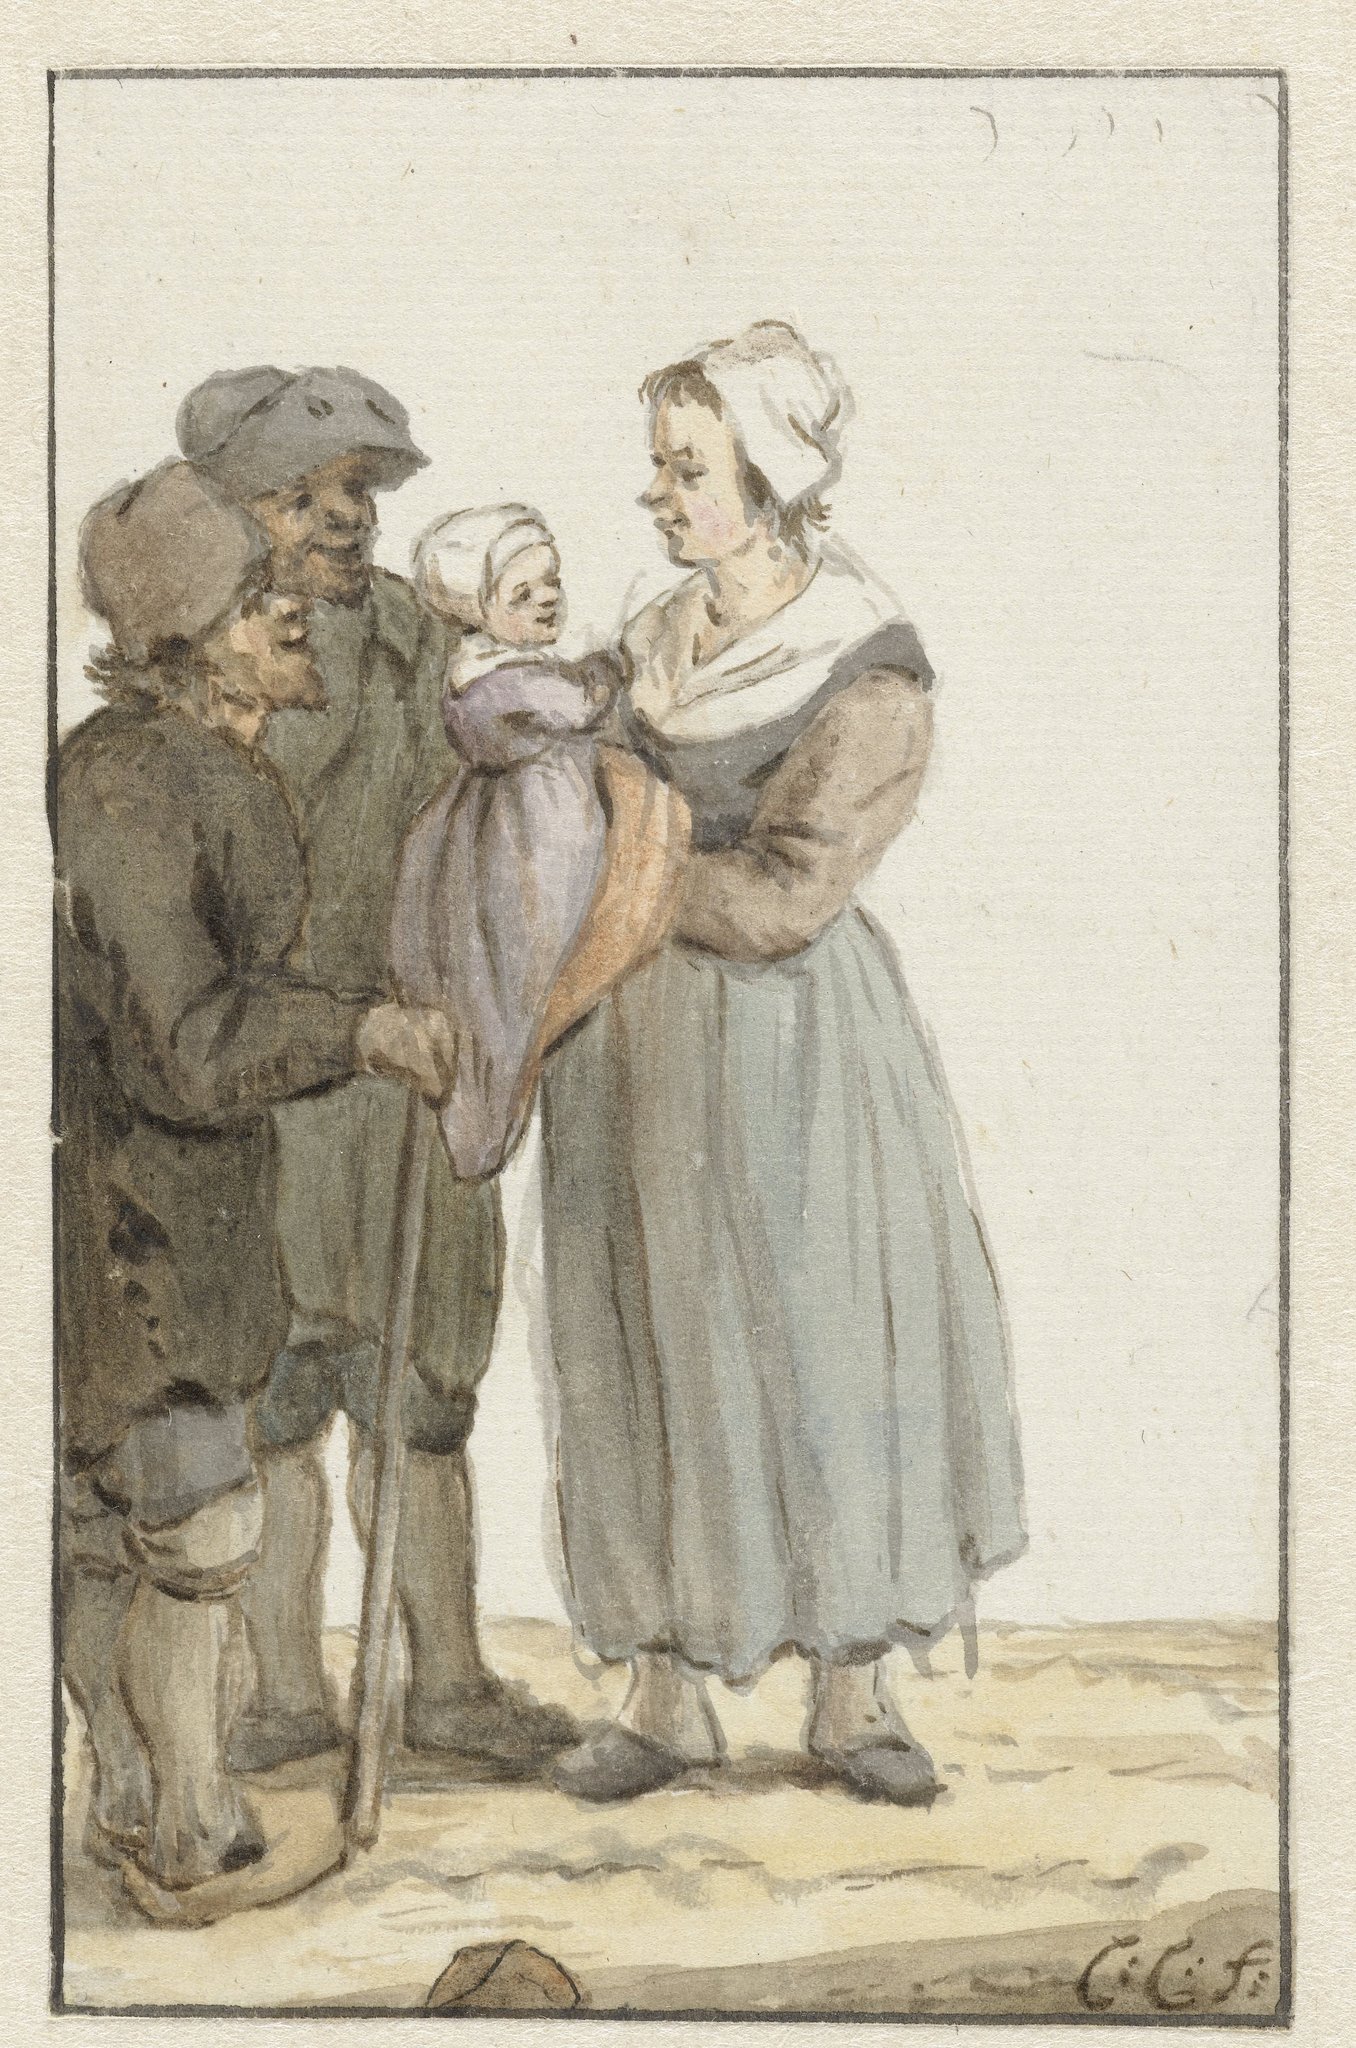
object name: drawing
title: Vrouw met kind bij twee mannen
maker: christina chalon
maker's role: draughtsman, print maker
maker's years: 1748-1808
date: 1758-1808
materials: ink, paper, watercolor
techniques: brush, pen